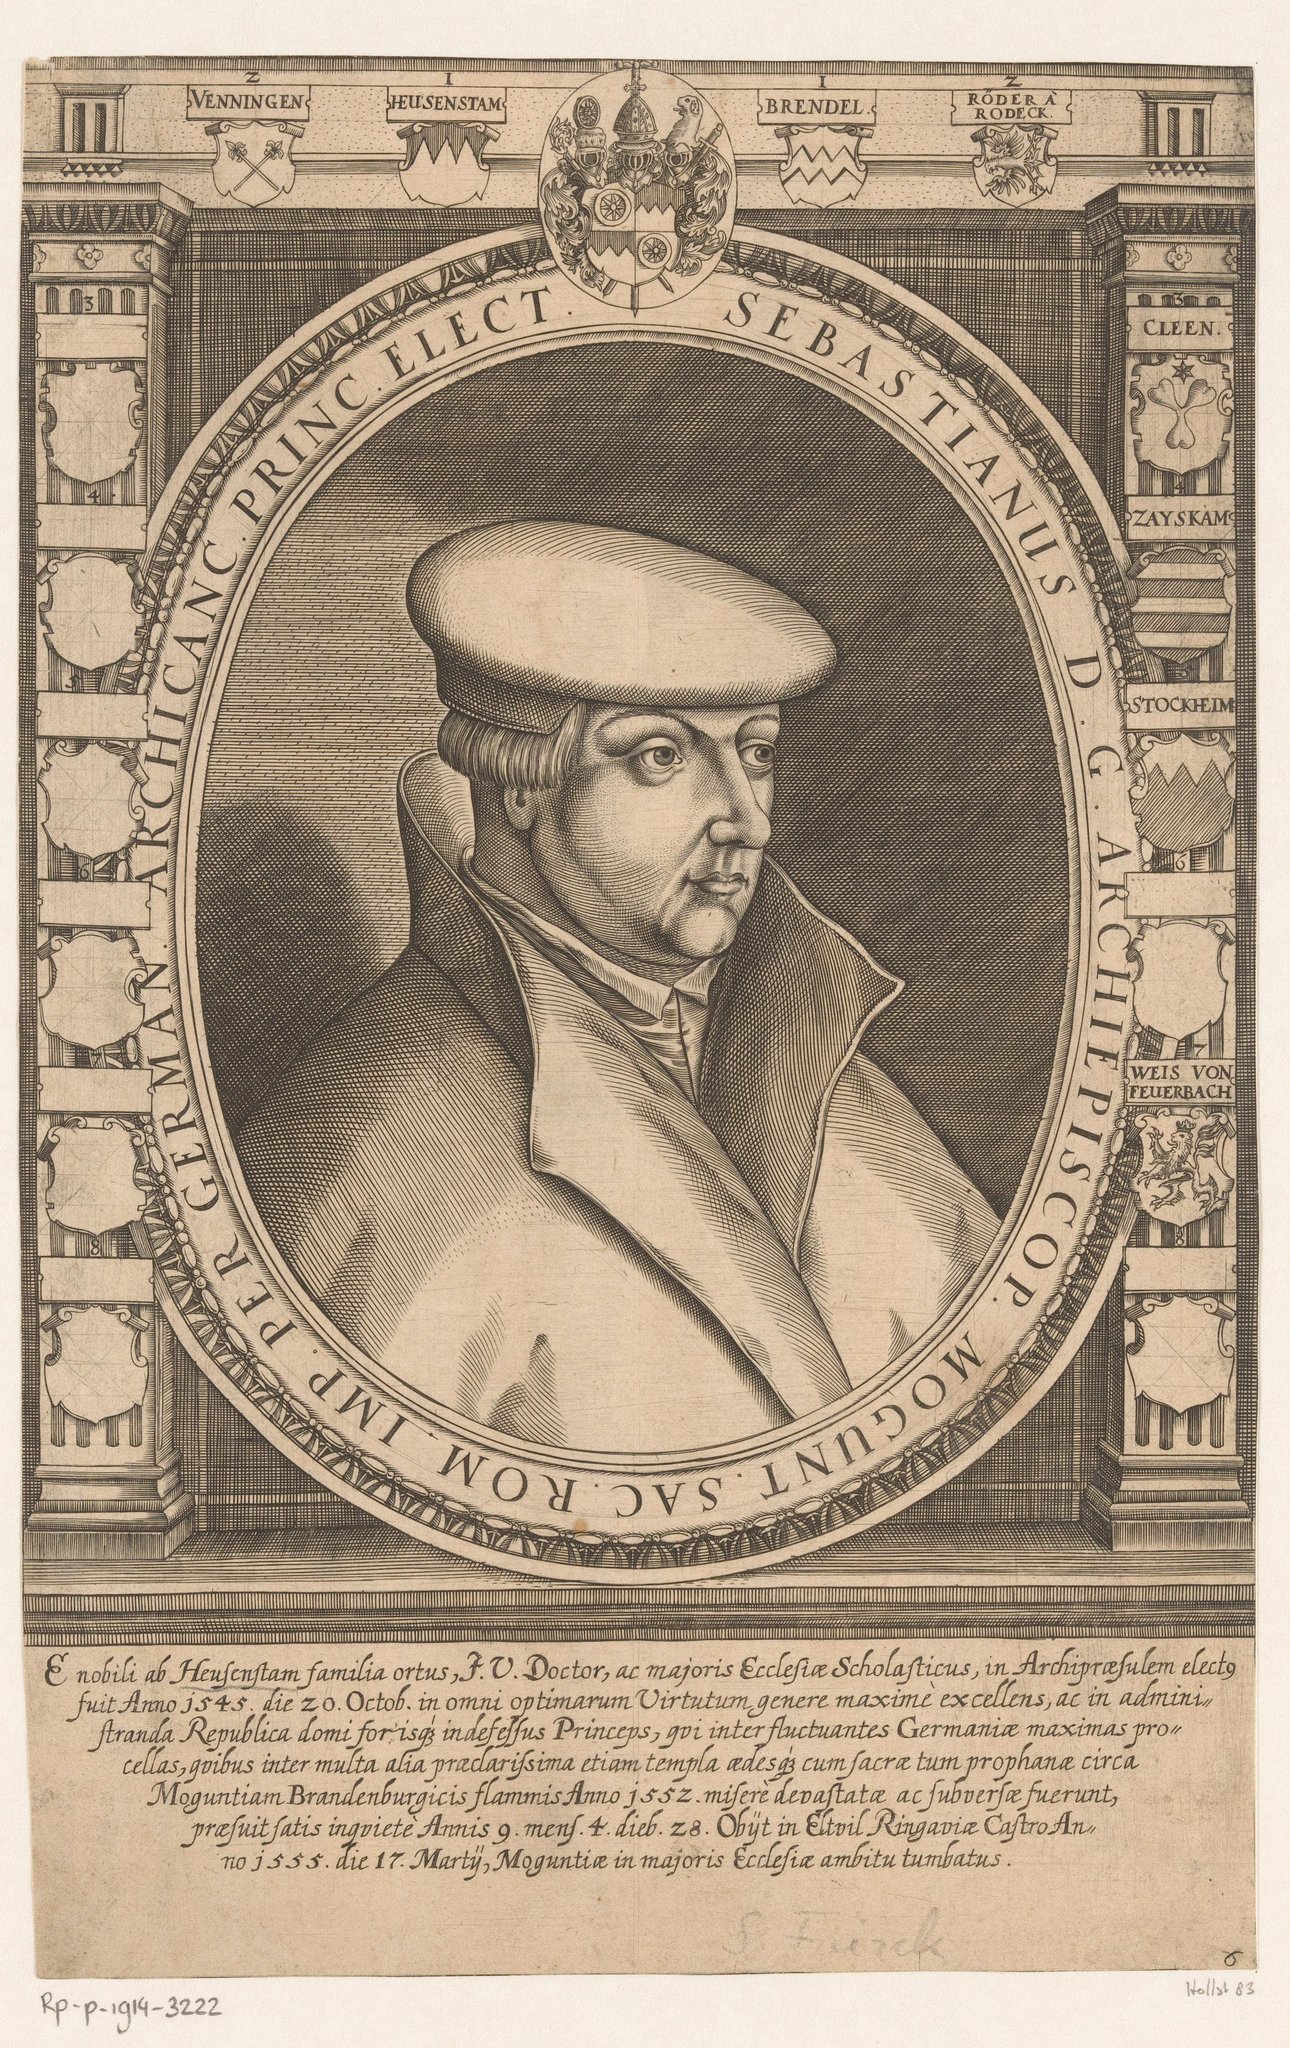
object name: print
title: Portret van Sebastian von Heusenstamm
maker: sebastian furck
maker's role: print maker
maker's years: 1600-1655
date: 1610-1655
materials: paper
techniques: engraving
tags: archbishop, bishop, etc. (roman catholic), historical persons, armorial bearing, heraldry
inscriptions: collector's mark: Lugt 2228